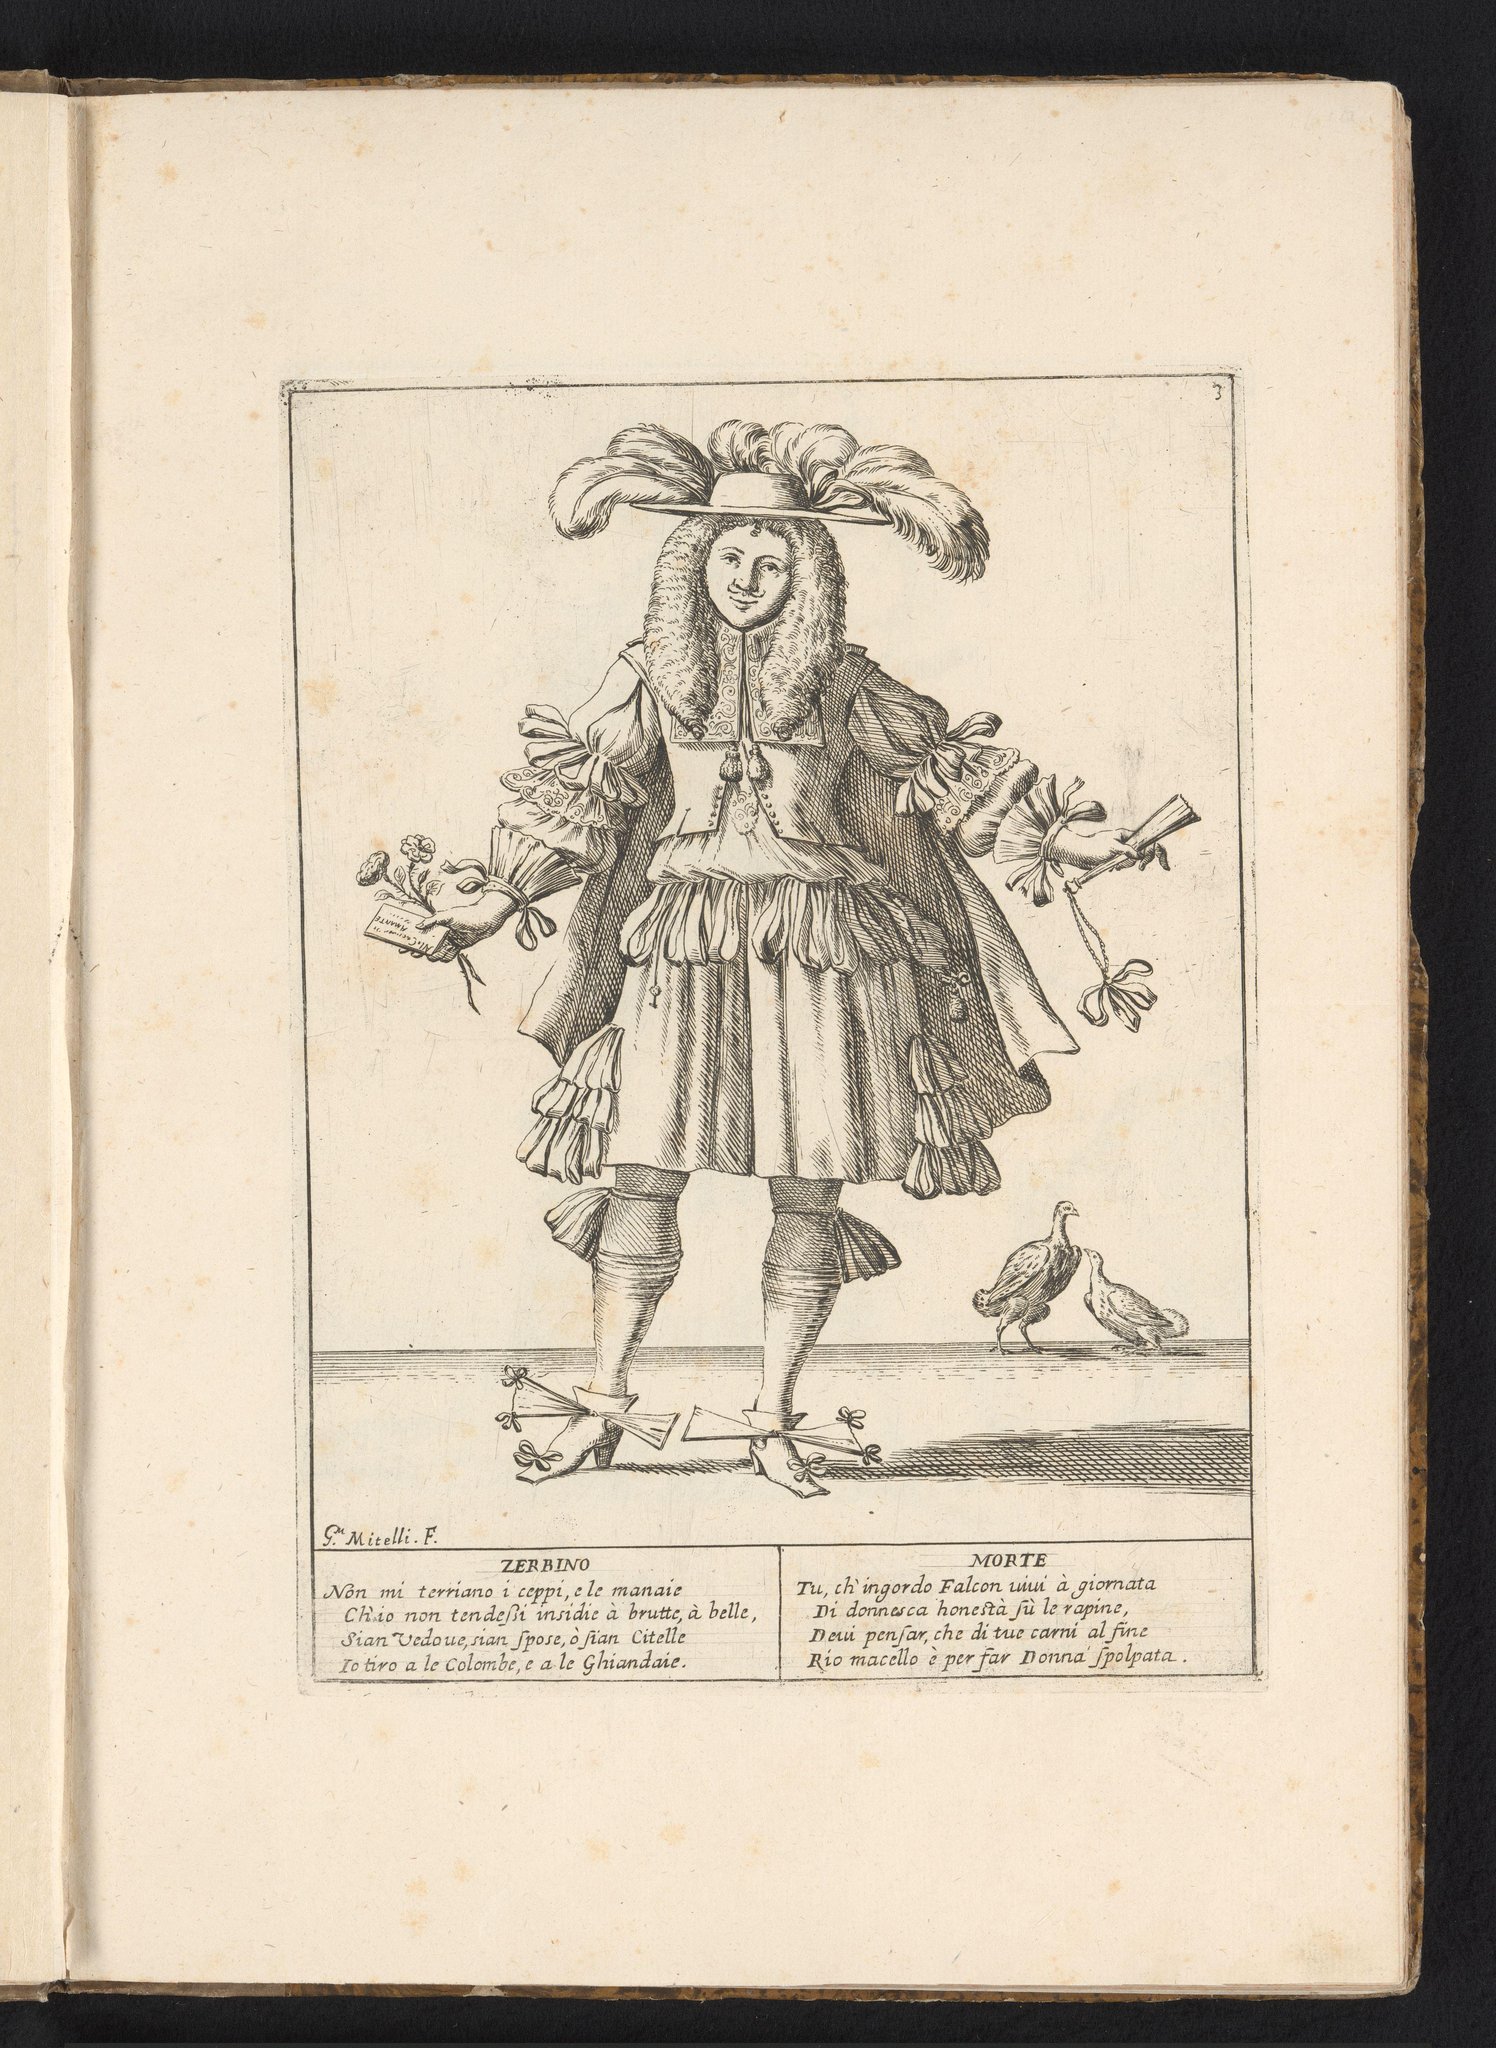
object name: print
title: Le Ventiquattr'Hore dell'humana felicità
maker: giuseppe maria mitelli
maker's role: draughtsman, painter, print maker, publisher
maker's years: 1634-1718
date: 1675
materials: paper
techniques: engraving, etching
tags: dandy, beau, scenes symbolizing 'vanitas', the 24 hours of day and night, bow (ornamental part of clothing), one-sided courting; pursuit; difficult choice, personifications ~ the life of man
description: Een kokette jonge man (Zerbino) modieus gekleed in linten, strikken en veren, om jonge vrouwen te verleiden. In de handen een waaier, bloem en liefdesbrief. Op de achtergrond twee fazanten. Met twee vierregelige verzen in het Italiaans. Genummerd rechtsboven: 3. Onderdeel van de serie 'De vierentwintig uren van het menselijk geluk'.